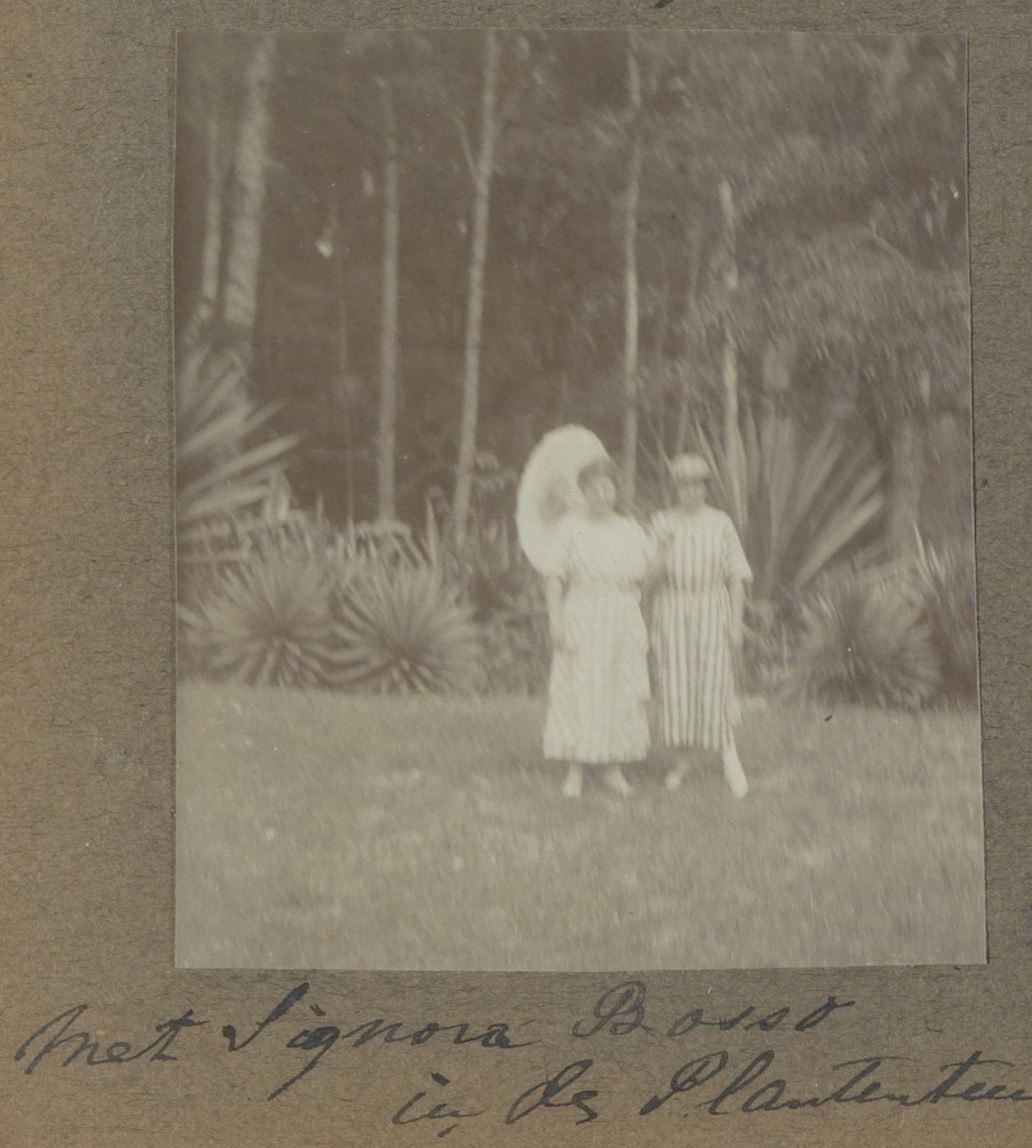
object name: photograph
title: Twee vrouwen in 's Lands Plantentuin in Buitenzorg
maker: Anonymous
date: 1920-1930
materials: photographic support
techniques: daylight paper print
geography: s lands plantentuin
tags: adult woman, botanic garden, 'hortus botanicus'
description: Onderdeel van fotoalbum van een onbekende Nederlandse familie met opnames van Suriname, Europa en Nederlands-Indië.